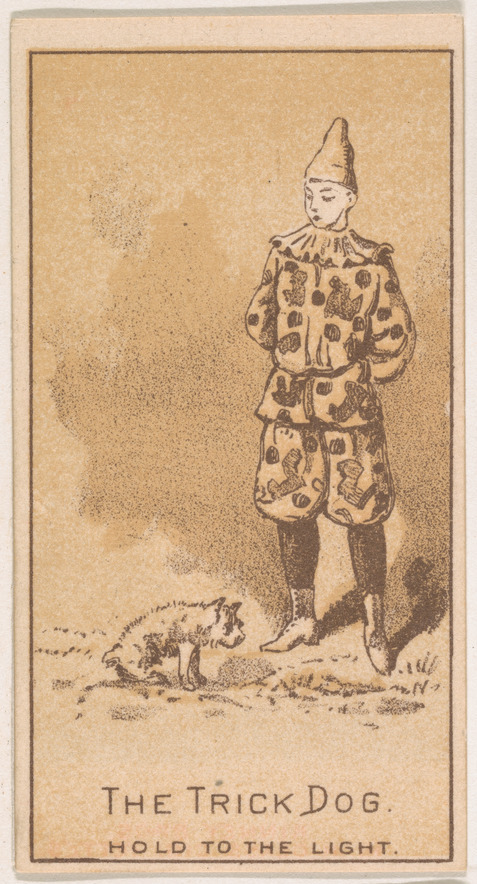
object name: print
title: The Trick Dog, from the Magic Changing Cards series (N223) issued by Kinney Tobacco Company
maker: kinney brothers tobacco company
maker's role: publisher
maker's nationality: american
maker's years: 1869-2011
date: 1889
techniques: color lithograph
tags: men,dogs